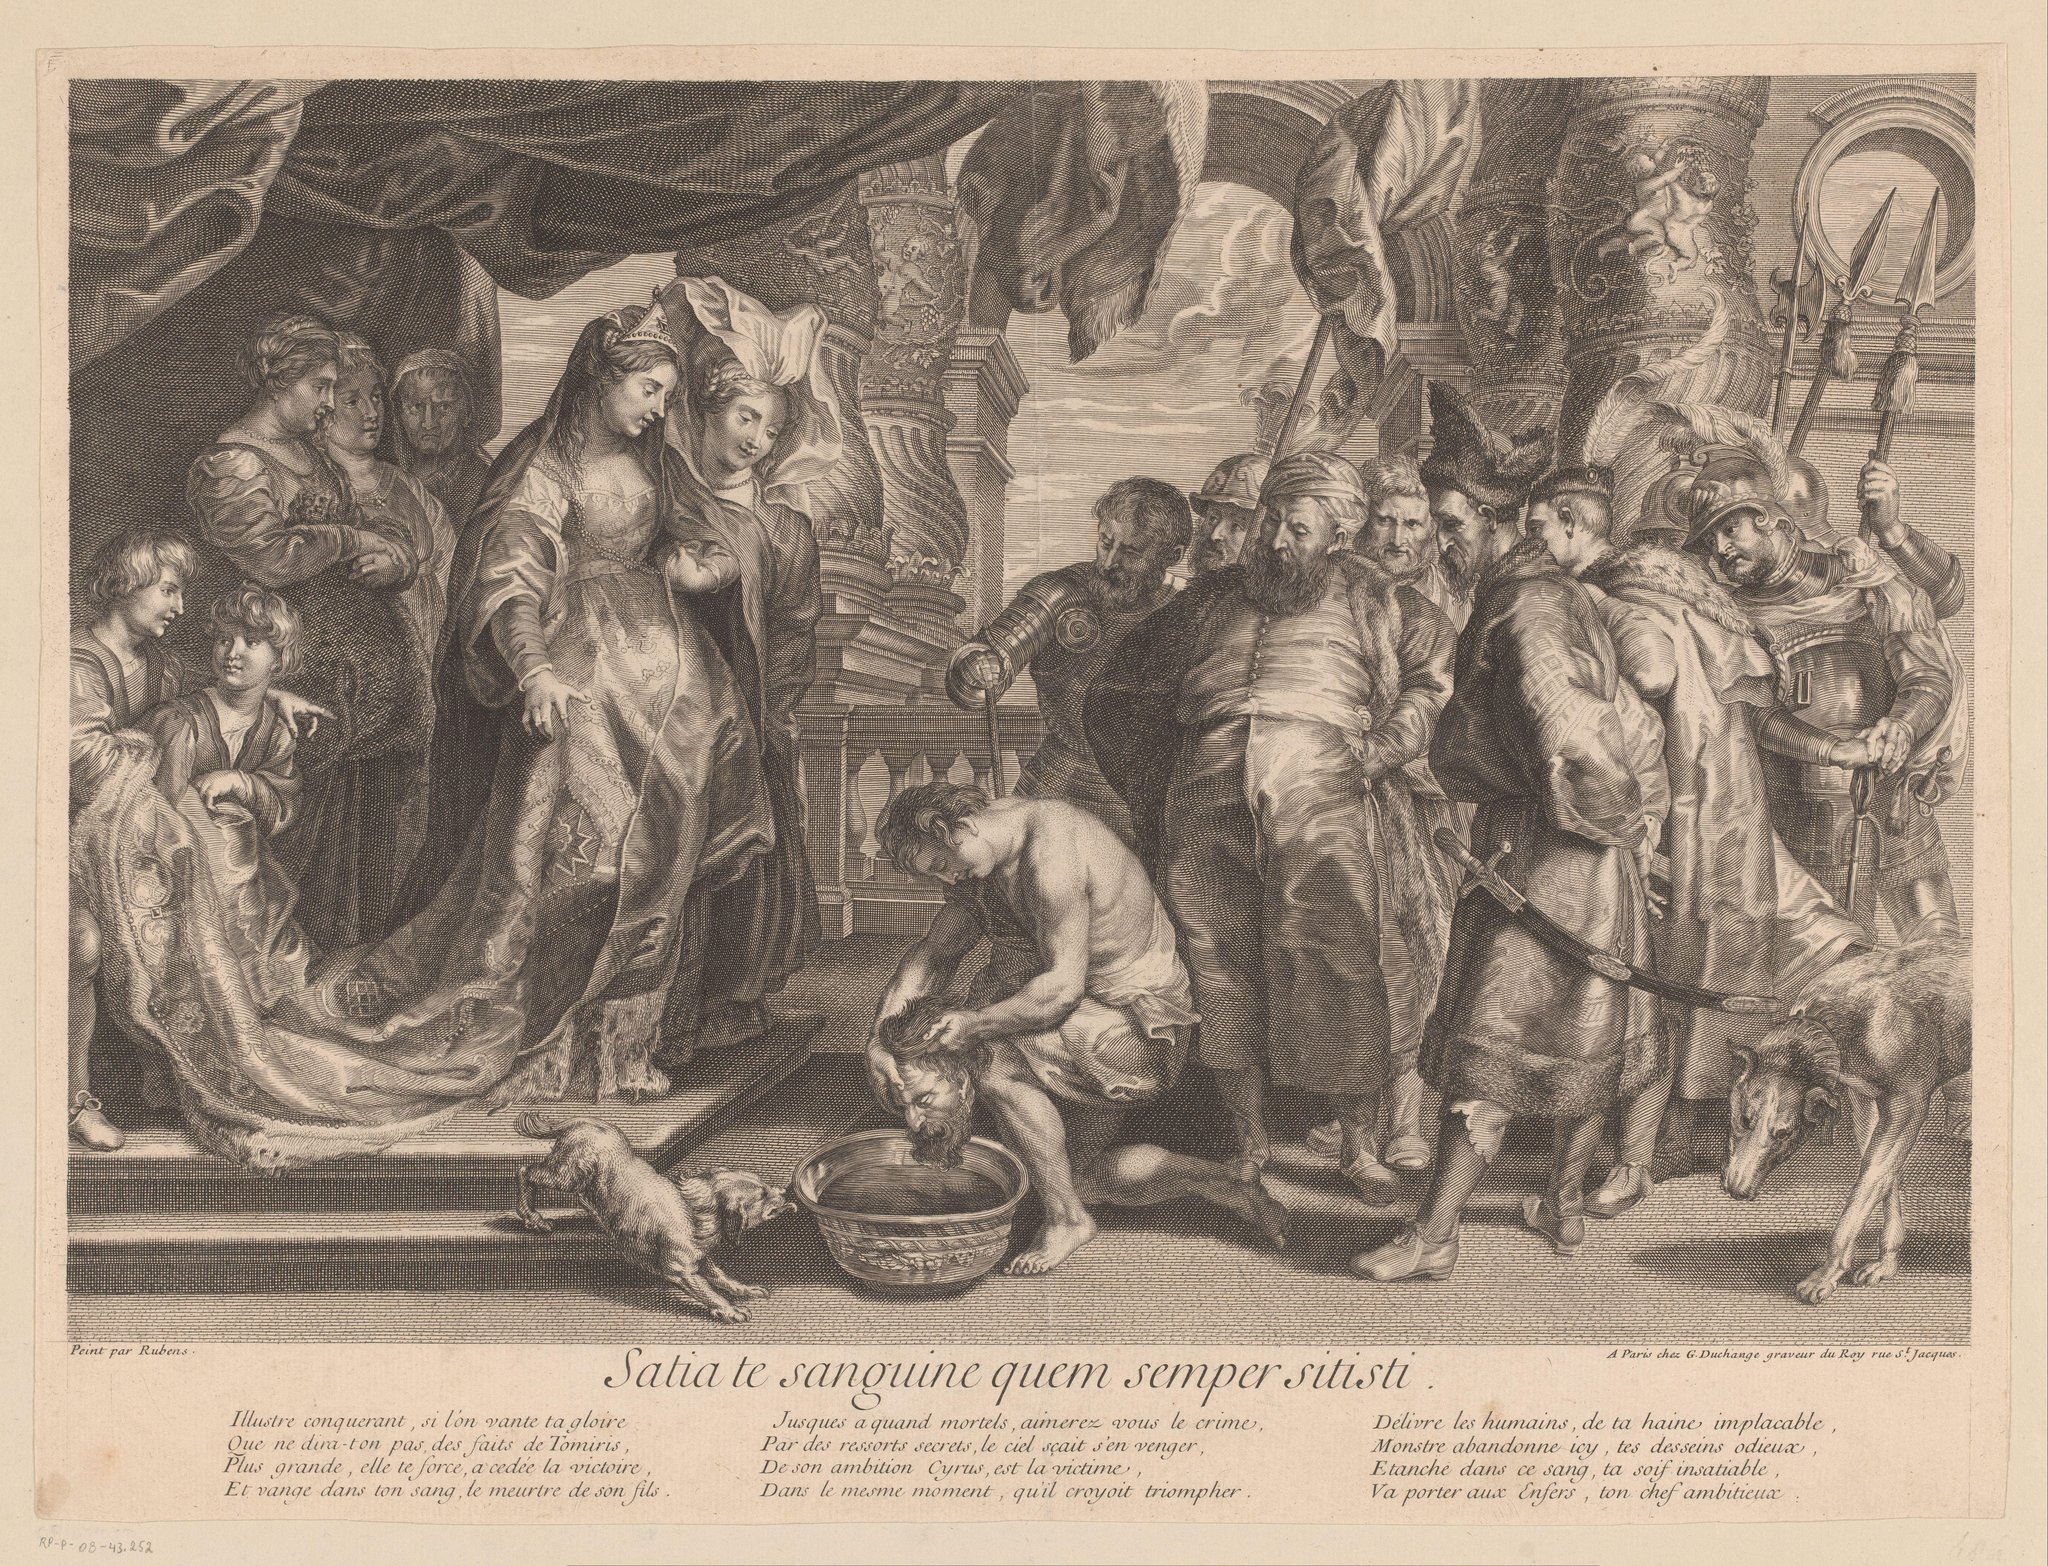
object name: print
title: Thomiris dompelt het hoofd van Cyrus in een kom bloed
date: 1672-1757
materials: paper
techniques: engraving, etching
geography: paris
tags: tomyris orders the head of the fallen cyrus to be cut off and dipped into a vessel of human blood, i.e. the vengeance of tomyris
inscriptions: collector's mark: Lugt 240